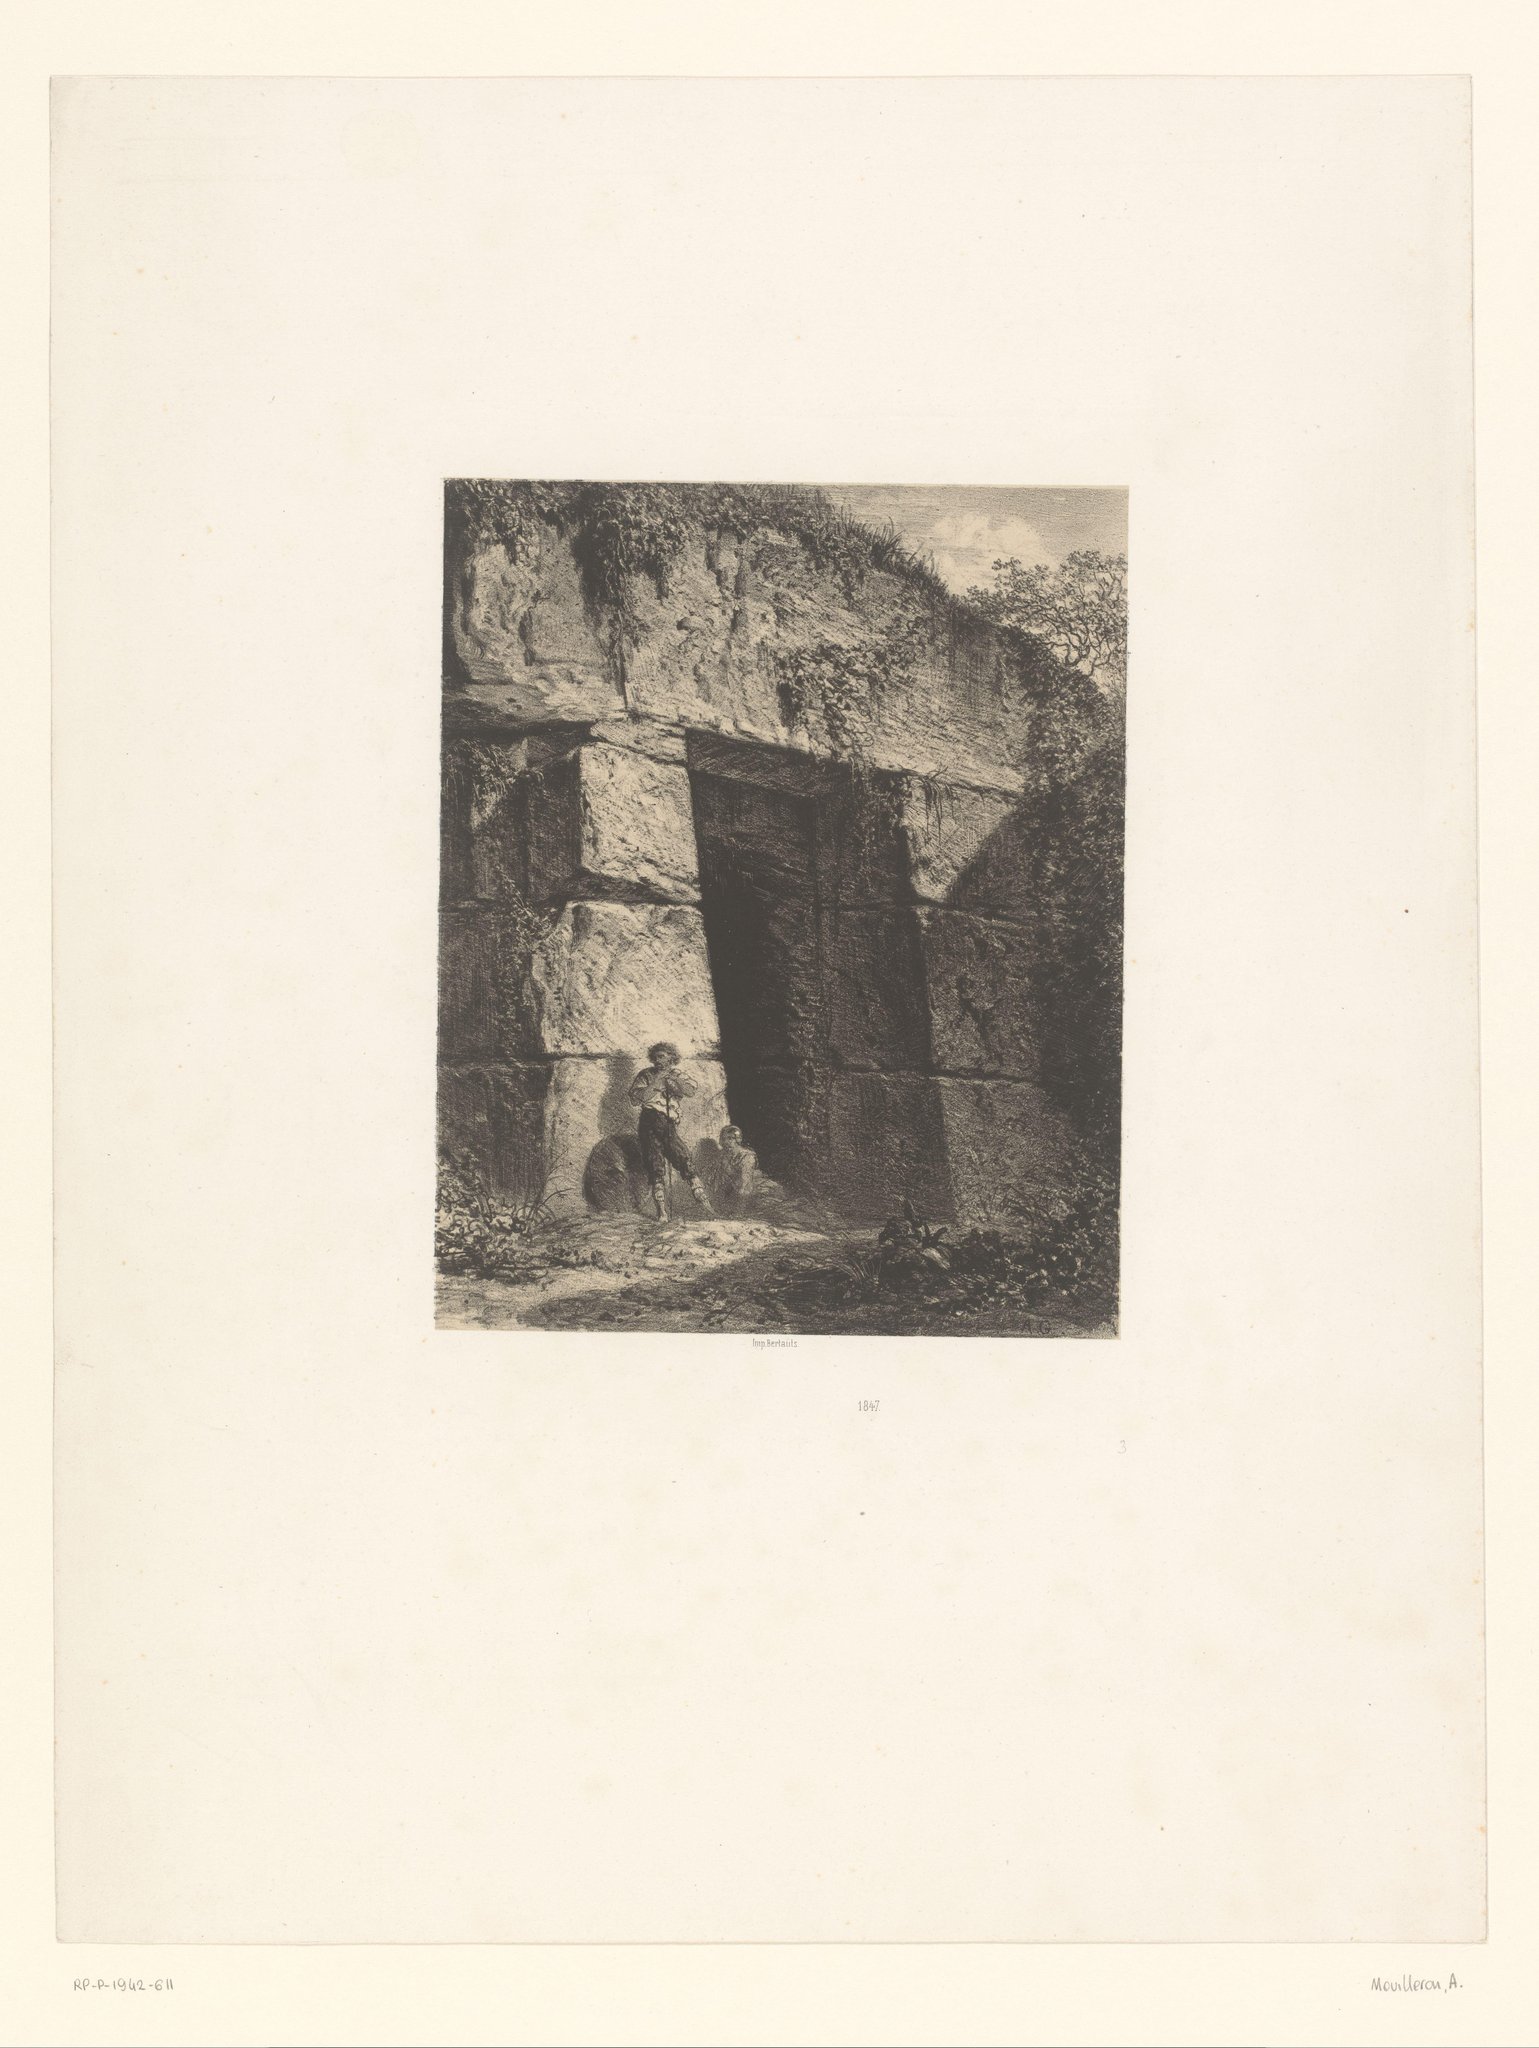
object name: print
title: Ingang van rotstunnel met wachters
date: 1847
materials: paper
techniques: lithograph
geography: paris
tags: guard duty, keeping sentry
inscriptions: collector's mark: Lugt 2228